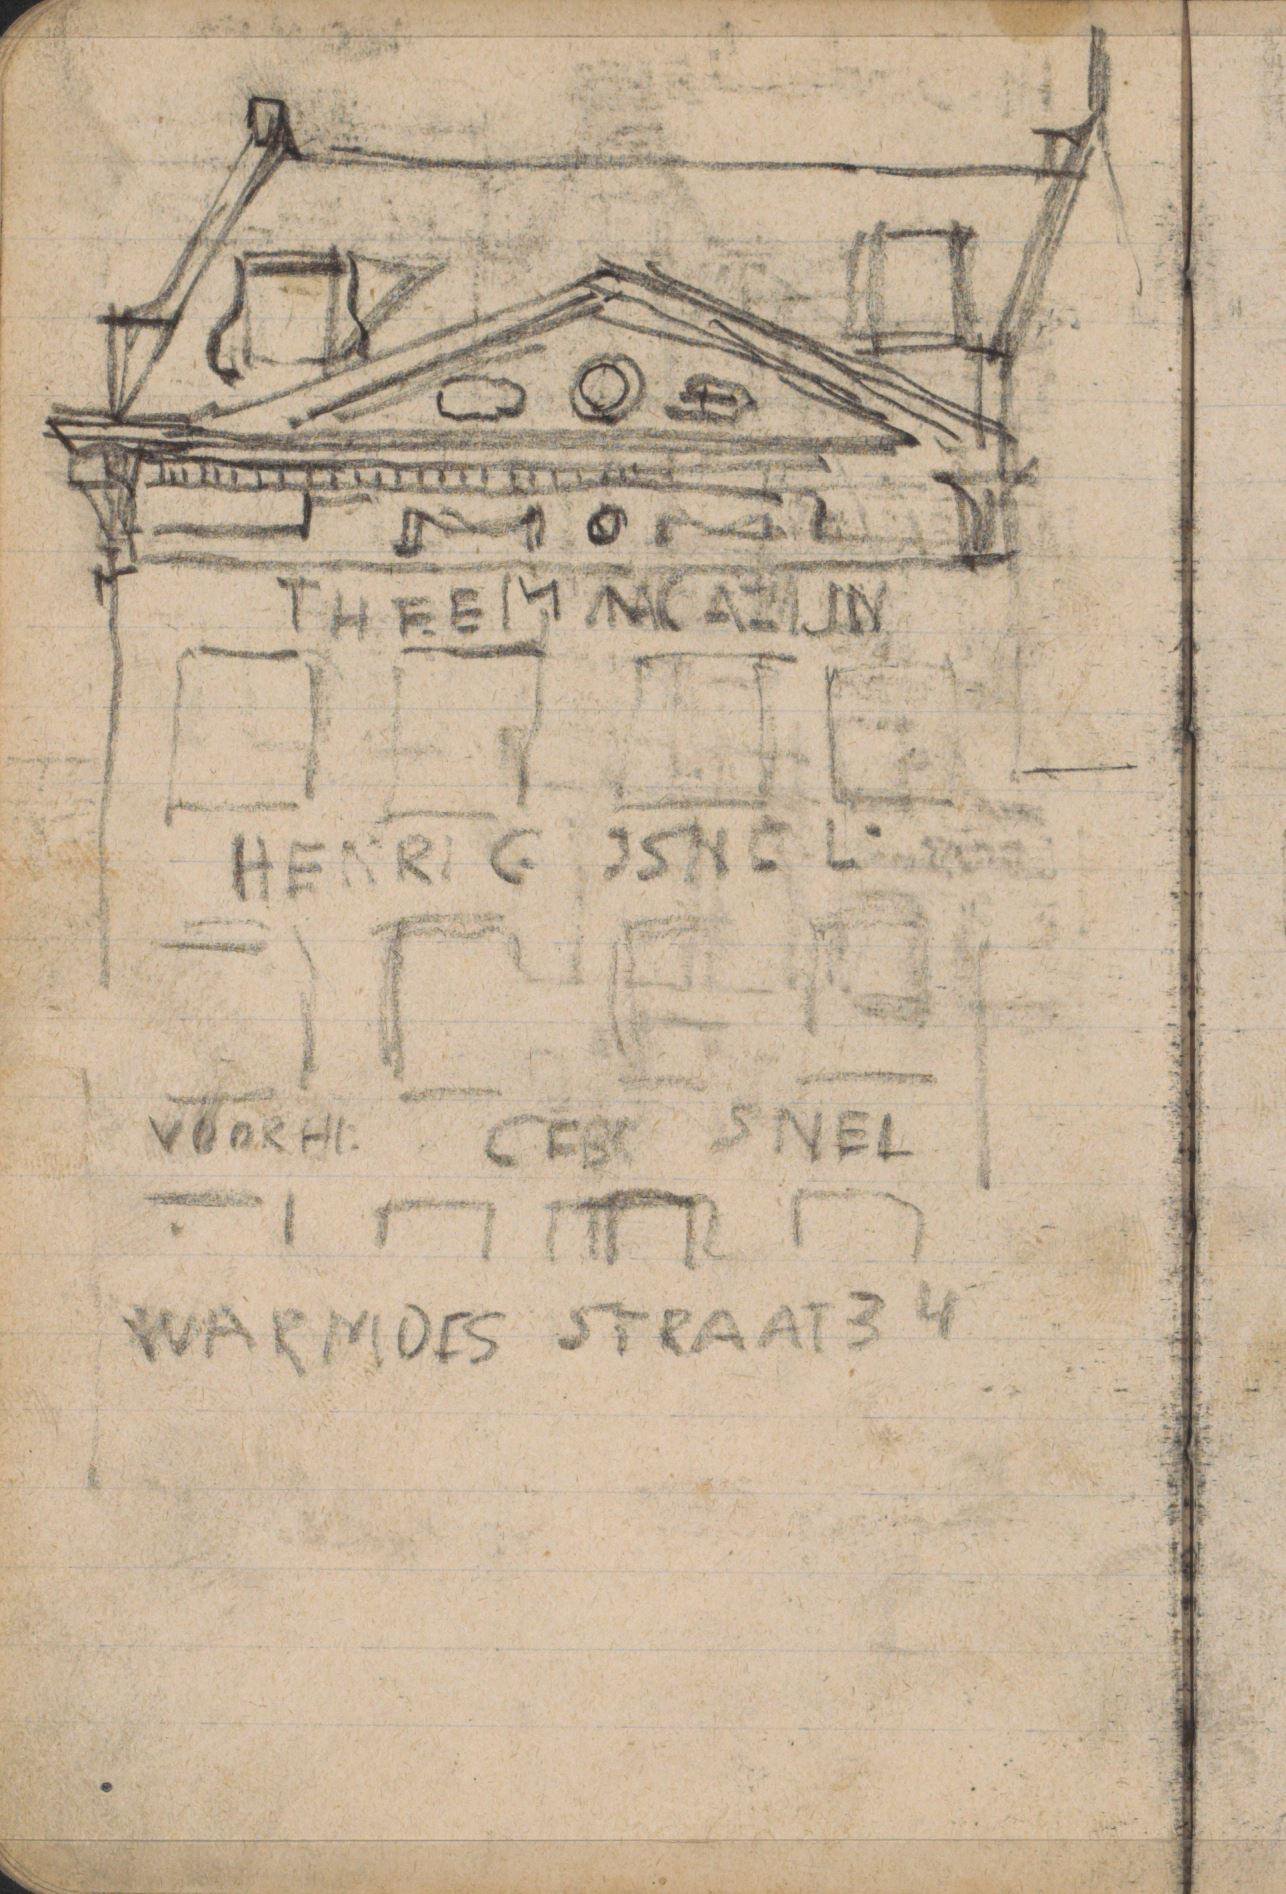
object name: sketchbook leaf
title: Gevel aan het Damrak te Amsterdam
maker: george hendrik breitner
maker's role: draughtsman, painter, print maker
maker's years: 1857-1923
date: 1902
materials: chalk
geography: amsterdam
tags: shop, store, civic architecture; edifices; dwellings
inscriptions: inscription: ‘Theemagazijn/ Henri G Snel/ [...] Gebr Snel/ Warmoesstraat 34’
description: Achterzijde van Warmoesstraat 34, het Theemagazijn van Snel. Pagina 37 uit een schetsboek met 32 bladen.